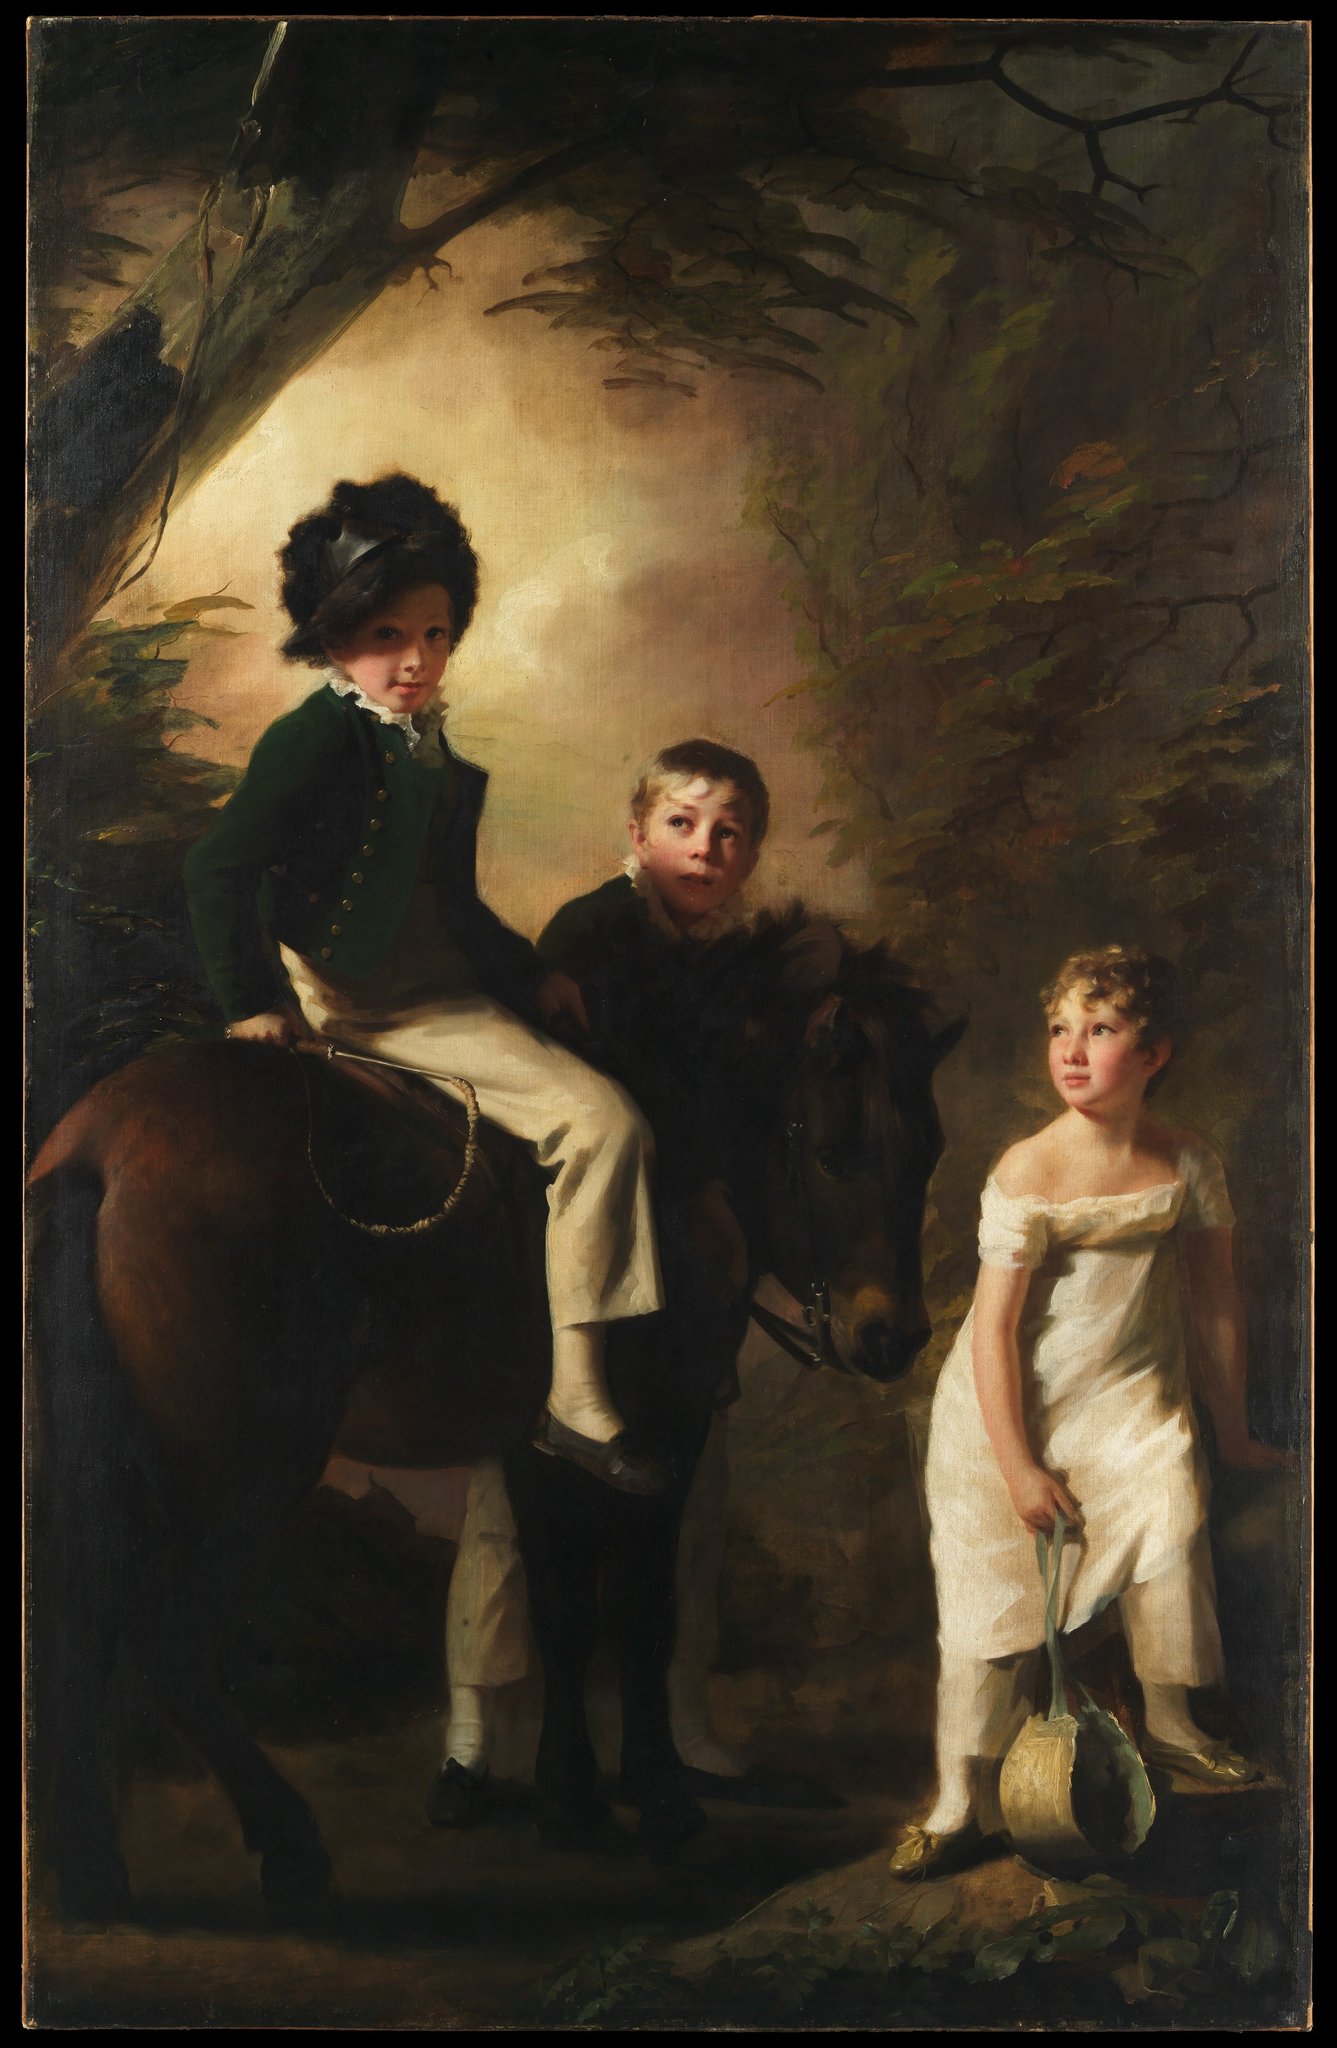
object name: painting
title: The Drummond Children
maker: sir henry raeburn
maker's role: artist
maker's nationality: british, scottish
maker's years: 1756-1923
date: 1808-1809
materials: canvas, oil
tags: boys,girls,portraits,horses